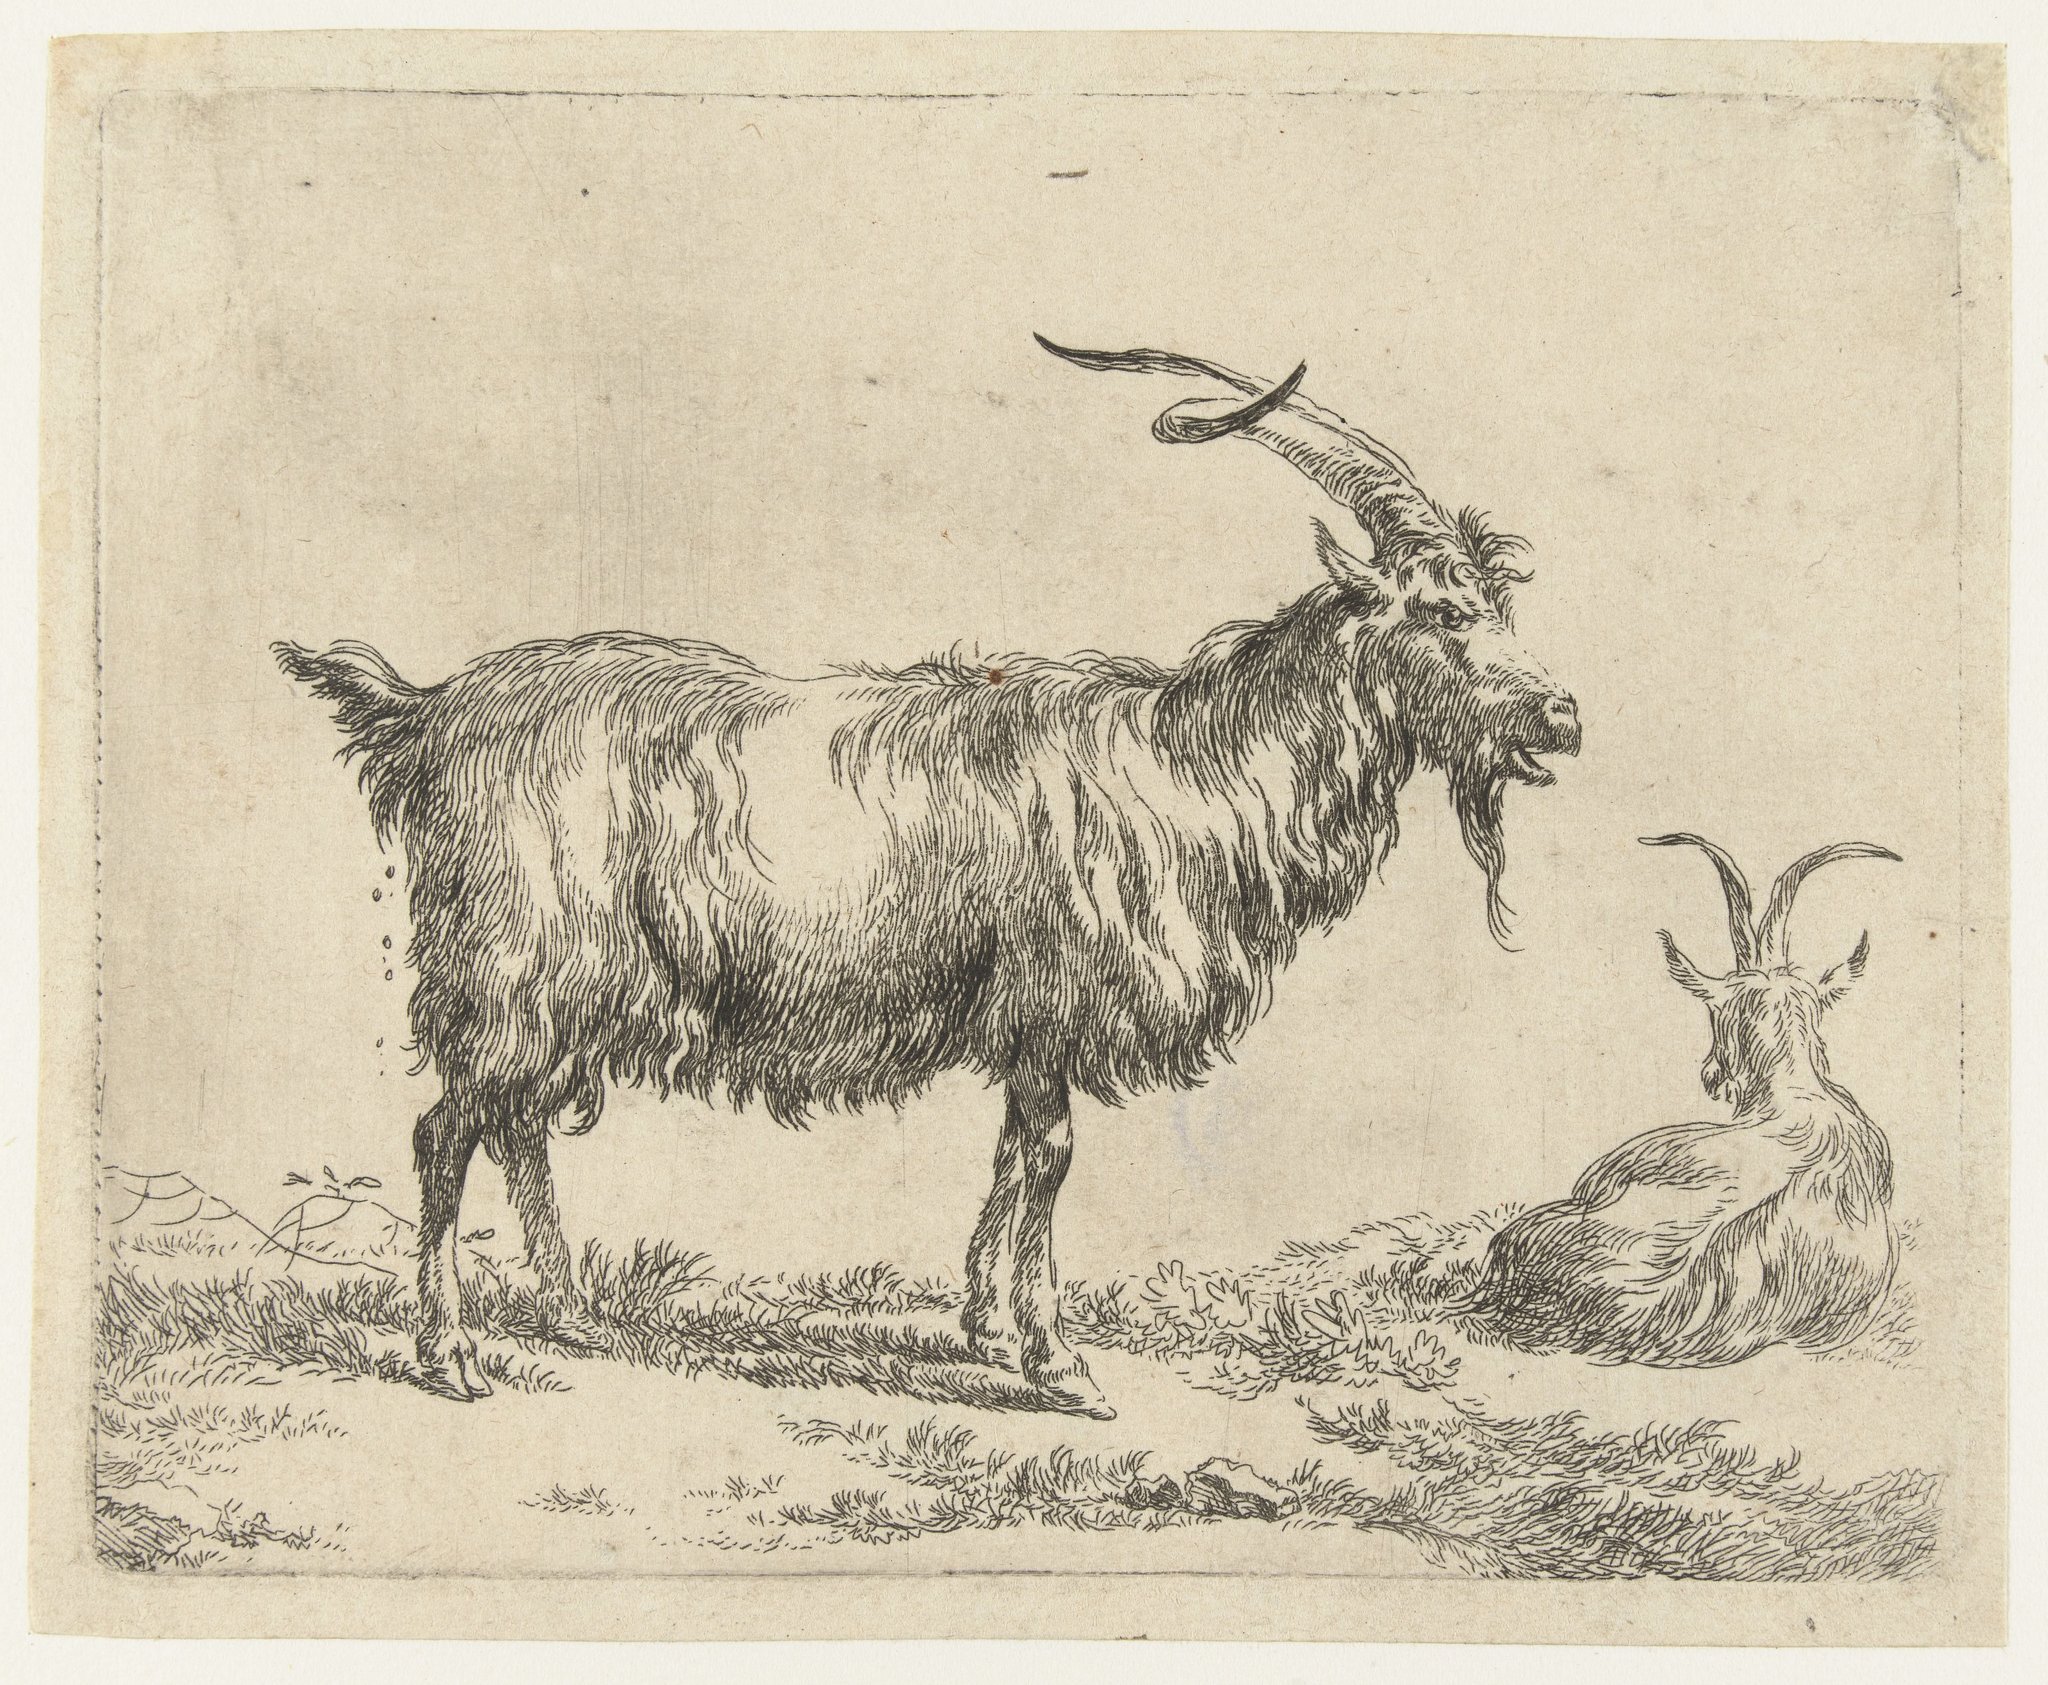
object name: print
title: Animalia ad vivum delineata et aqua forti aeri impressa Studio et Arte Nicolai Berchemi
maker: nicolaes pietersz berchem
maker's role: draughtsman, print maker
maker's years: 1620-1683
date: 1648-1652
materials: paper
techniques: etching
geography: netherlands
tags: goat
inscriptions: collector's mark: Lugt 240